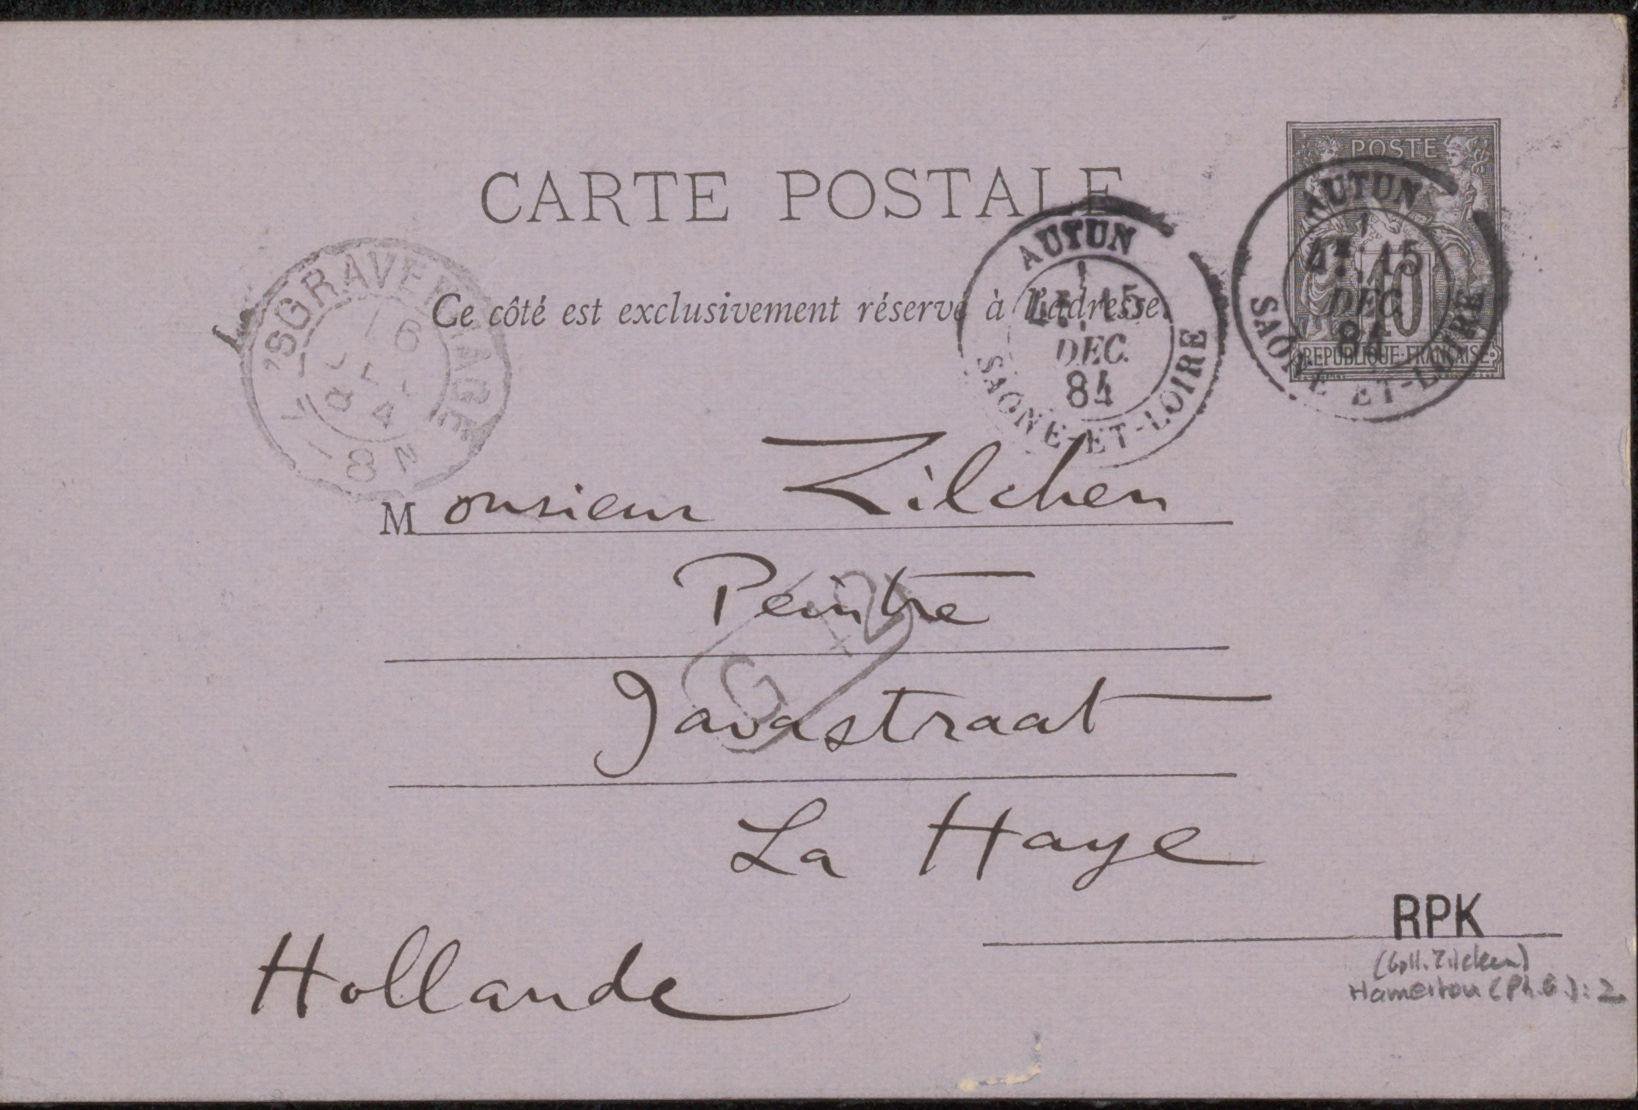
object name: postcard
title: Briefkaart aan Philip Zilcken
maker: philip gilbert hamerton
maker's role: print maker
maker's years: 1834-1894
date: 1884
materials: cardboard, ink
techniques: pen, writing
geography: autun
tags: the hague, painter, draughtsman, philip zilcken, the graphic arts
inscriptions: collector's mark: ‘RPK’